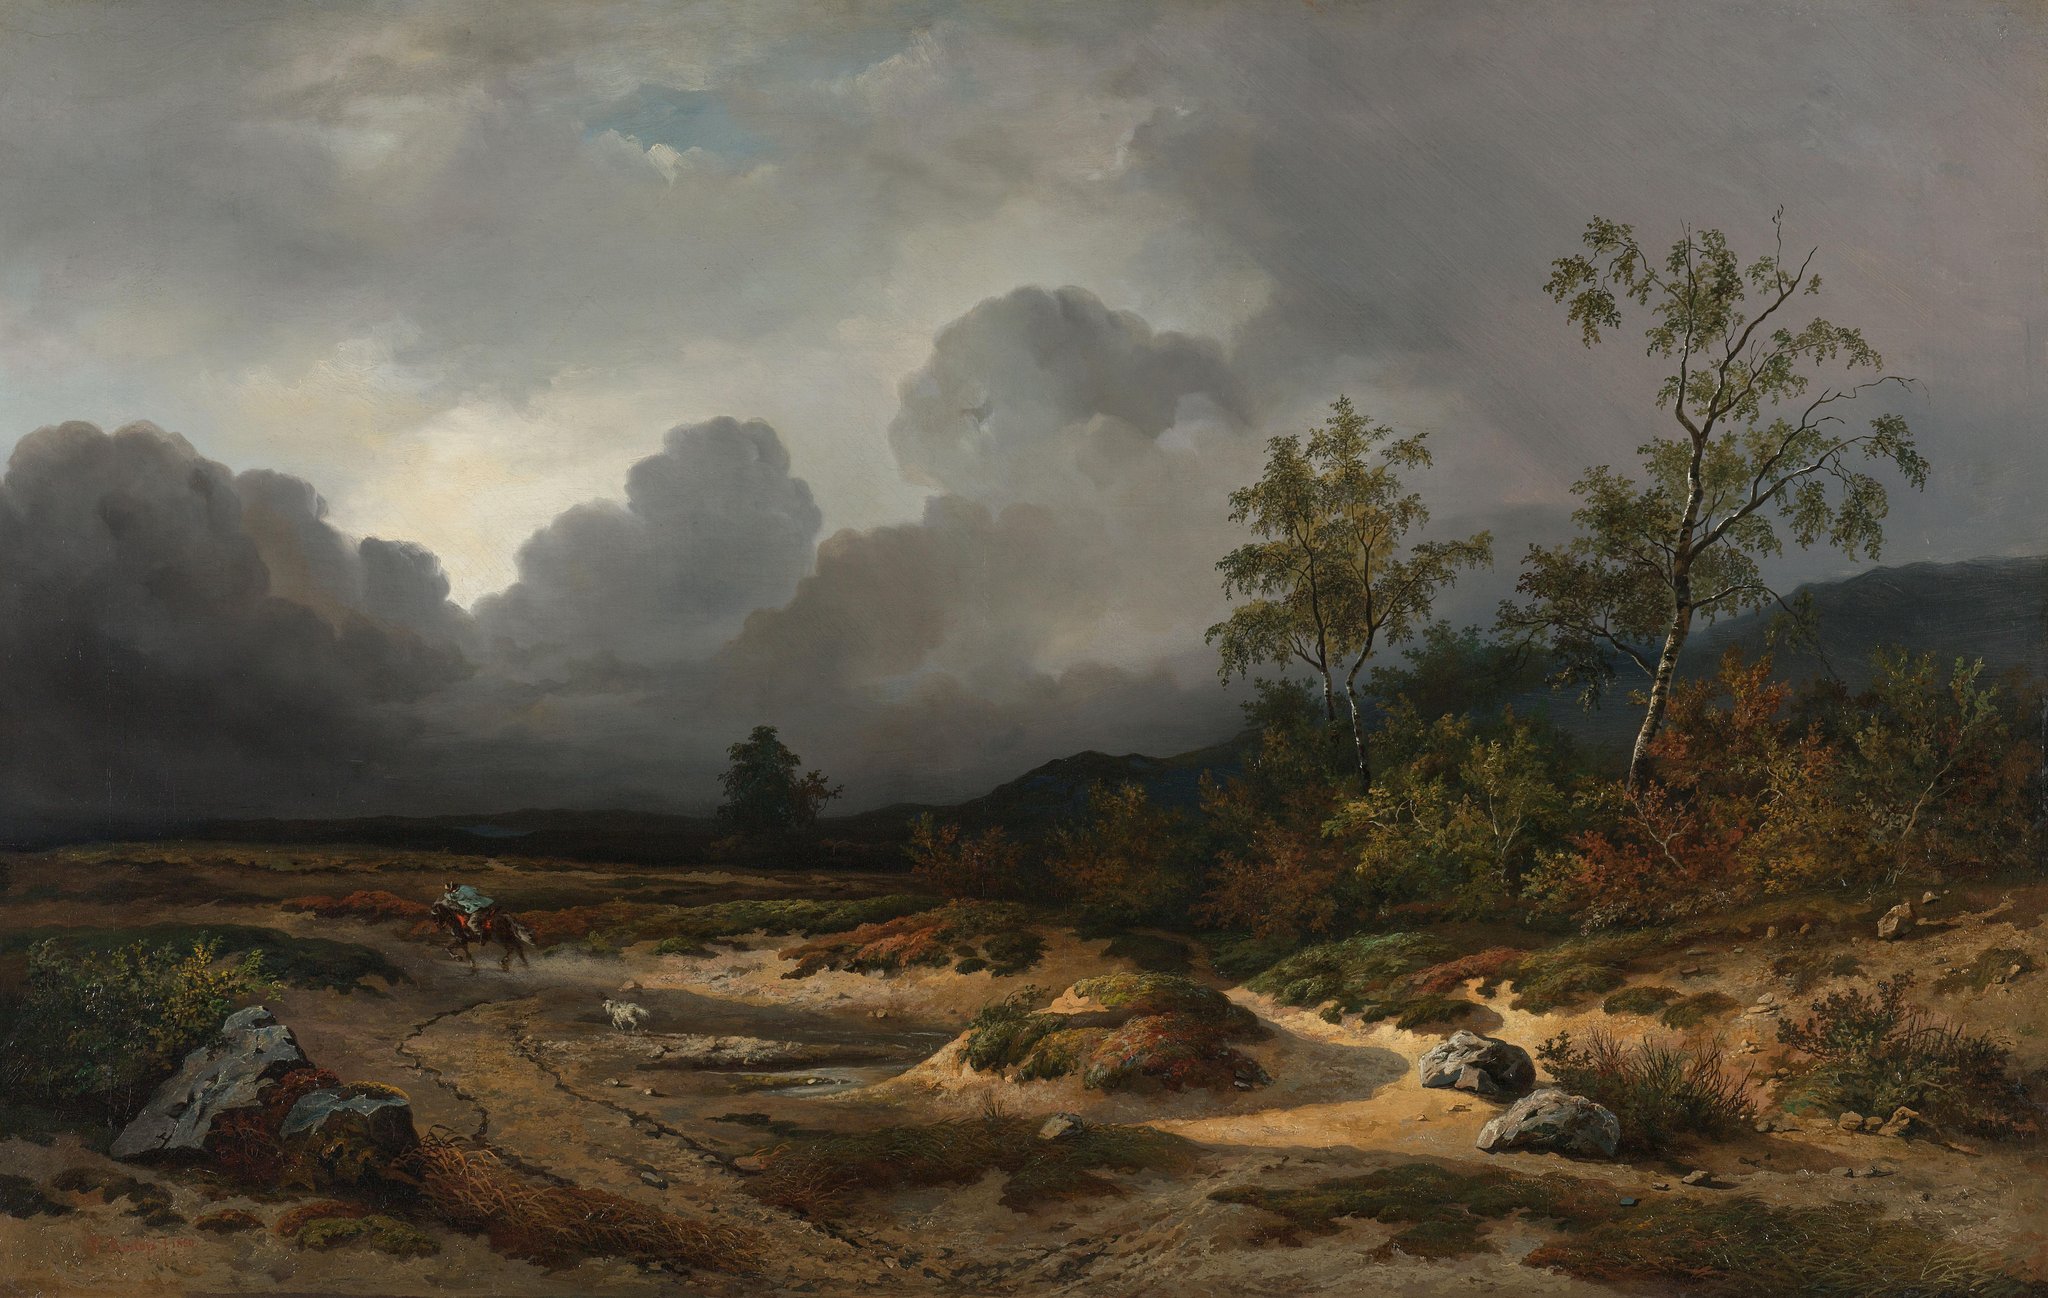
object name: painting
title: Landscape with a Thunderstorm Brewing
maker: willem roelofs (i)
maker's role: draughtsman, painter, print maker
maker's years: 1822-1897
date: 1850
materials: canvas, oil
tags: riding a horse, ass, or mule; rider, horseman, landscapes in the temperate zone, thunderstorm, dog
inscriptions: signature and date: ‘W. Roelofs f. 1850’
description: This landscape is full of drama and contrasts. Such impressive views were very popular in the first half of the 19th century. Whether they presented a realistic scene was irrelevant; they were made to convey the grandeur and power of nature and to strike an emotional chord.